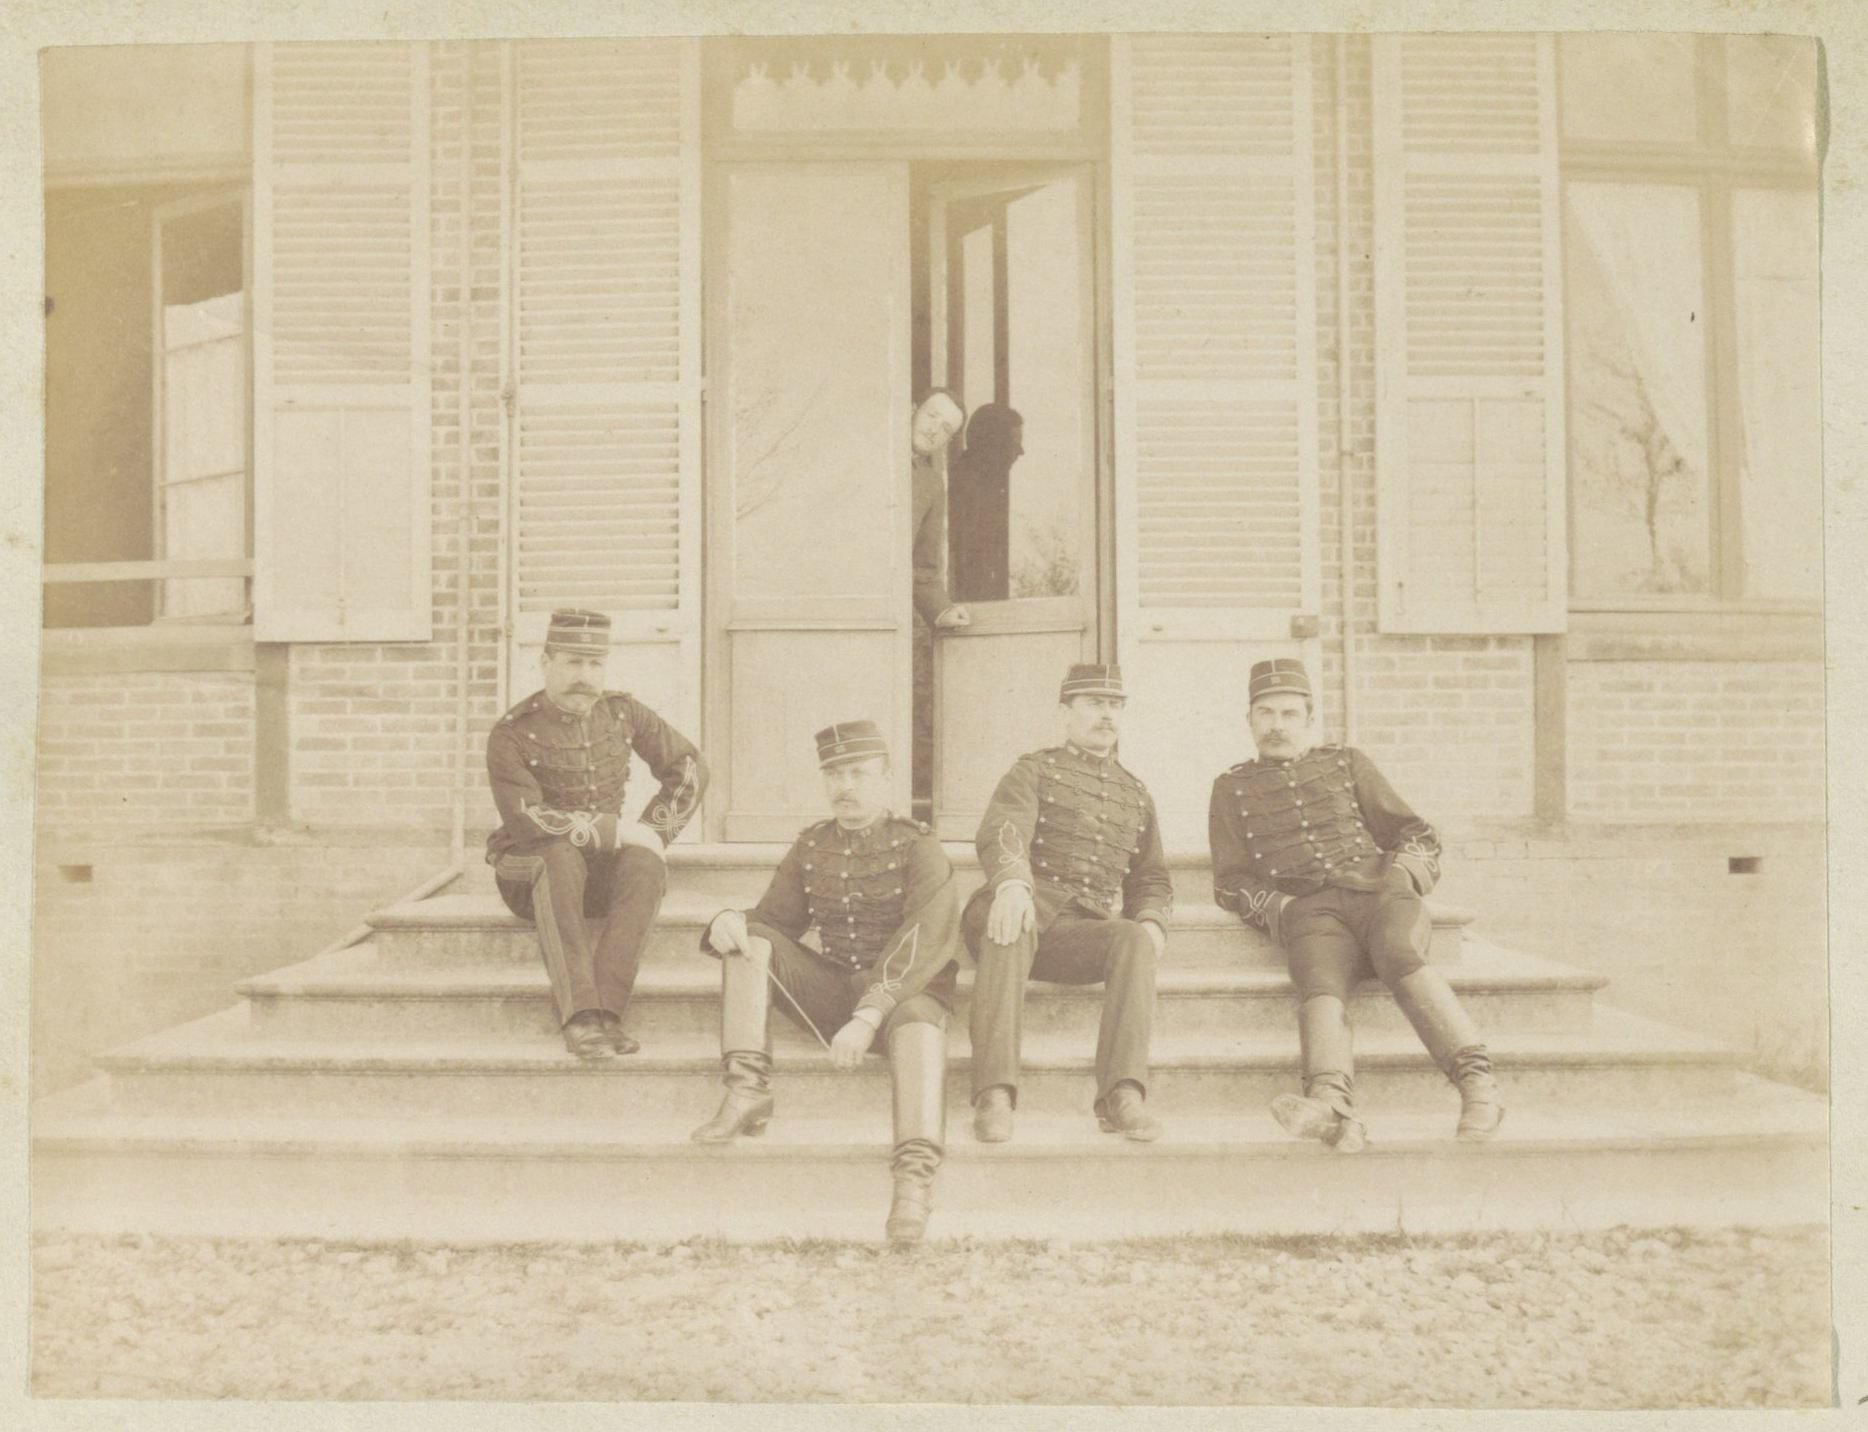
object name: photograph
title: Groepsportret van vijf Franse militairen poserend op de trappen voor een huis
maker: Anonymous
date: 1805-1884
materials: photographic support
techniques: albumen print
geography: france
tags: land forces, (military) uniforms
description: Onderdeel van Album van een Franse amateurfotograaf met opnames van familie, militairen, industrie, landschappen en bezienswaardigheden in Frankrijk.